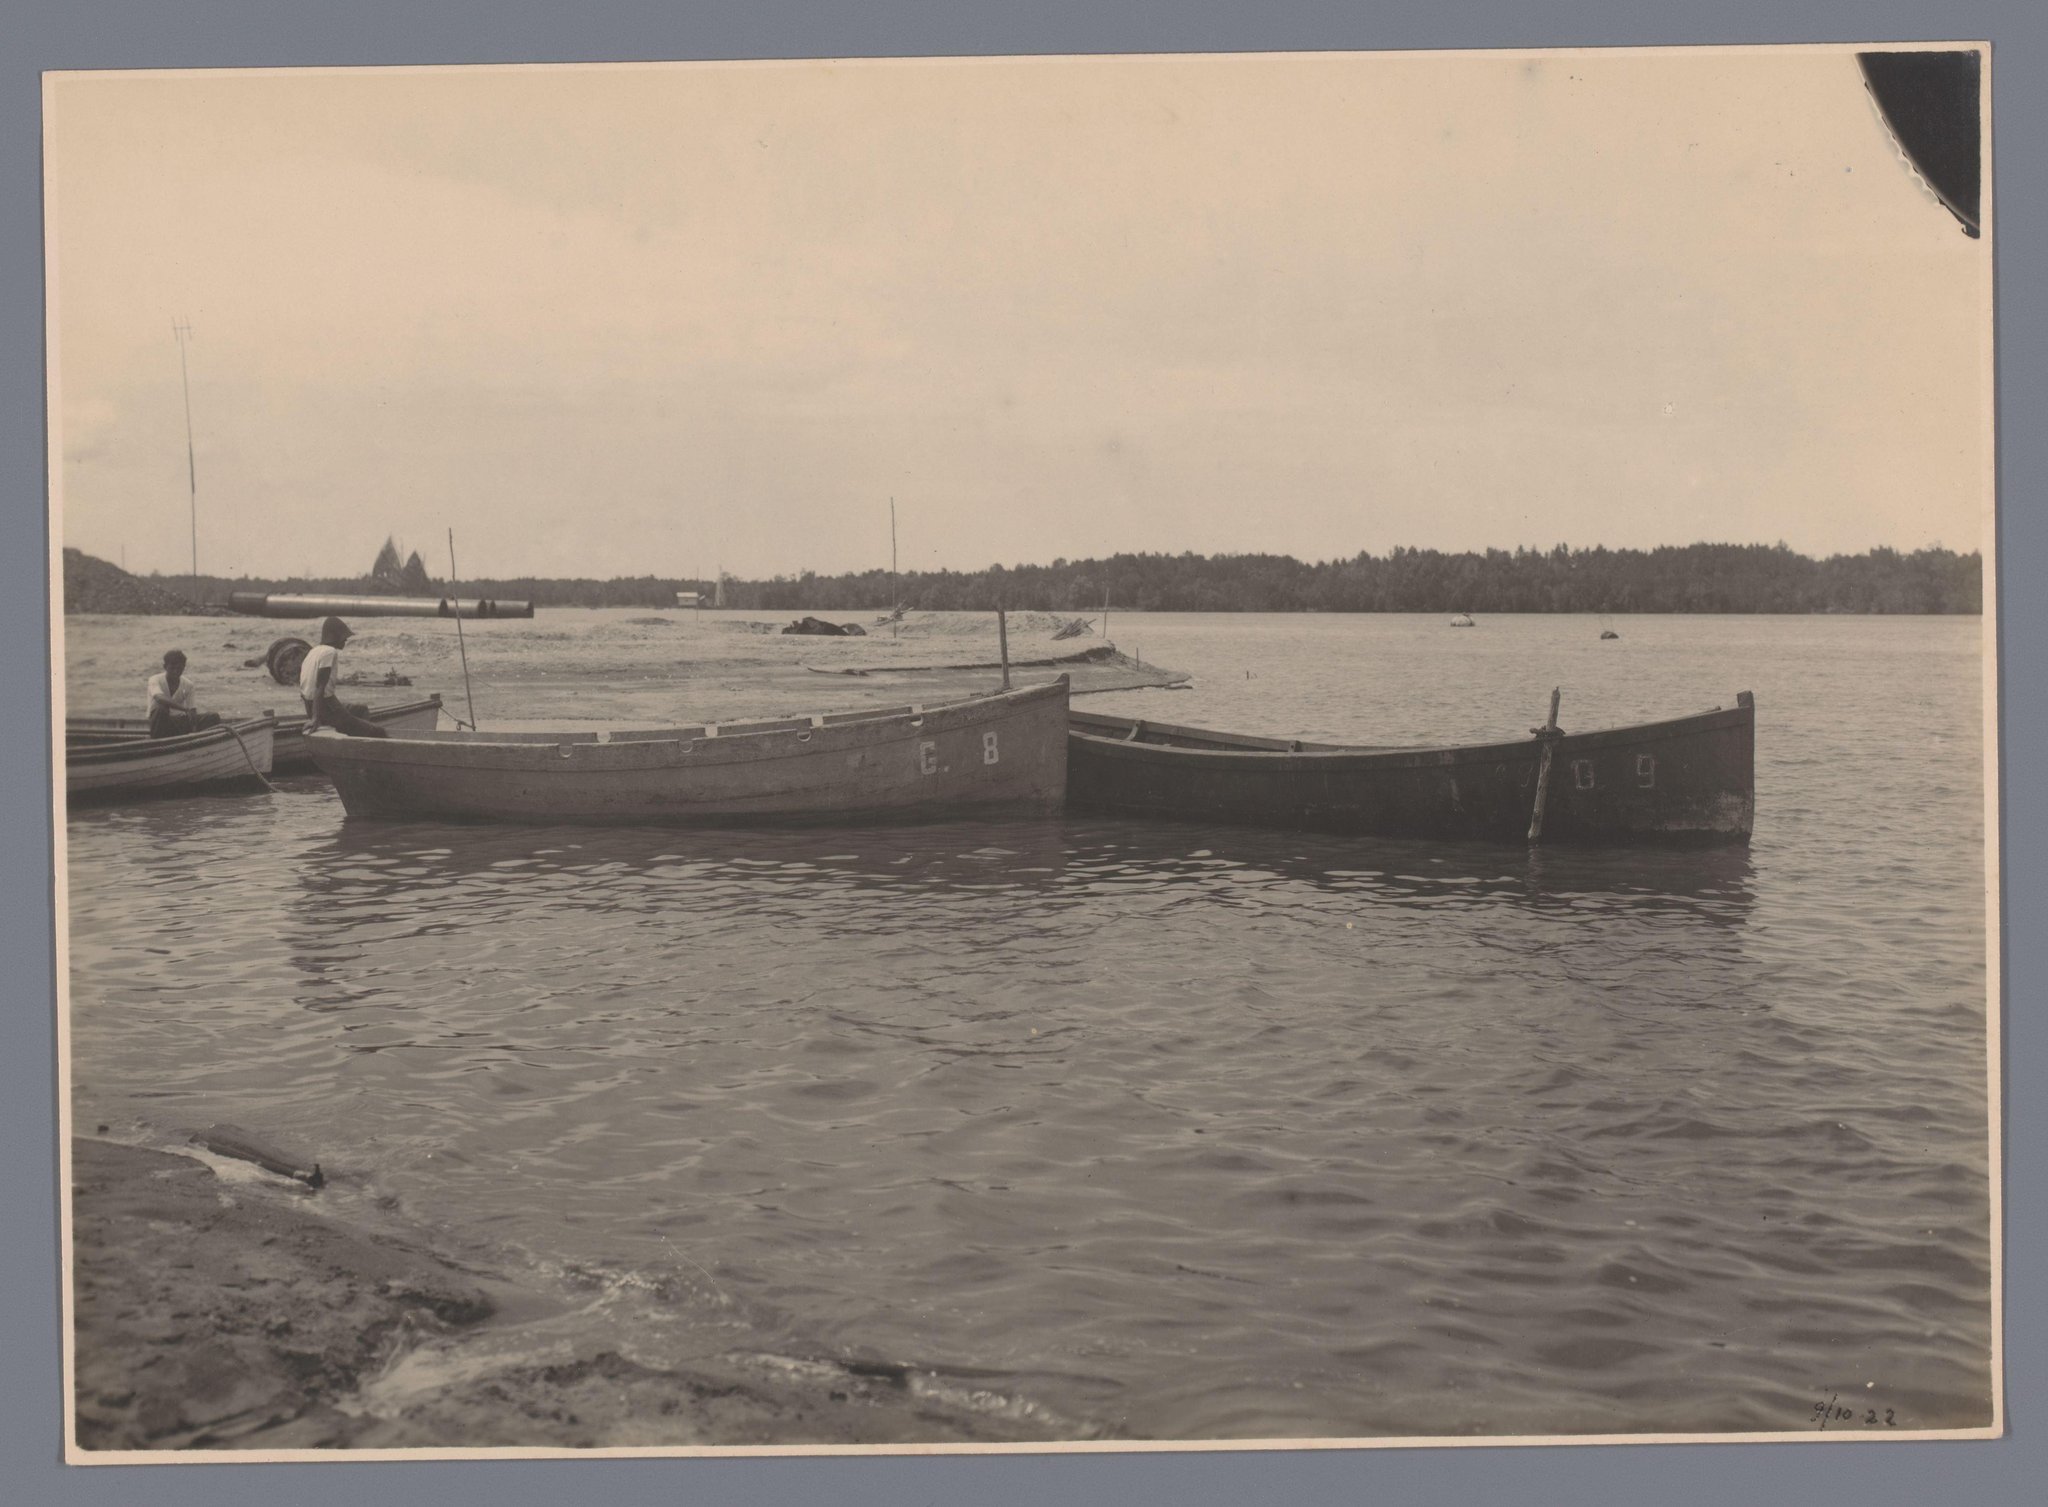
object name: photograph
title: Roeibooten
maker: Anonymous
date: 1922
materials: photographic support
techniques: gelatin silver print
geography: belawan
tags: rowing-boat, canoe, etc., building-site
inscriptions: date: ‘9/10-22’, annotation: ‘No. 244 Roeibooten’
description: Twee roeiboten van de bouwonderneming 'G8' en 'G97'. Genummerd: 244. Onderdeel van de groep van losse foto's over de aanleg van de haven Belawan aan de kust voor Medan, Sumatra 1921-1922.